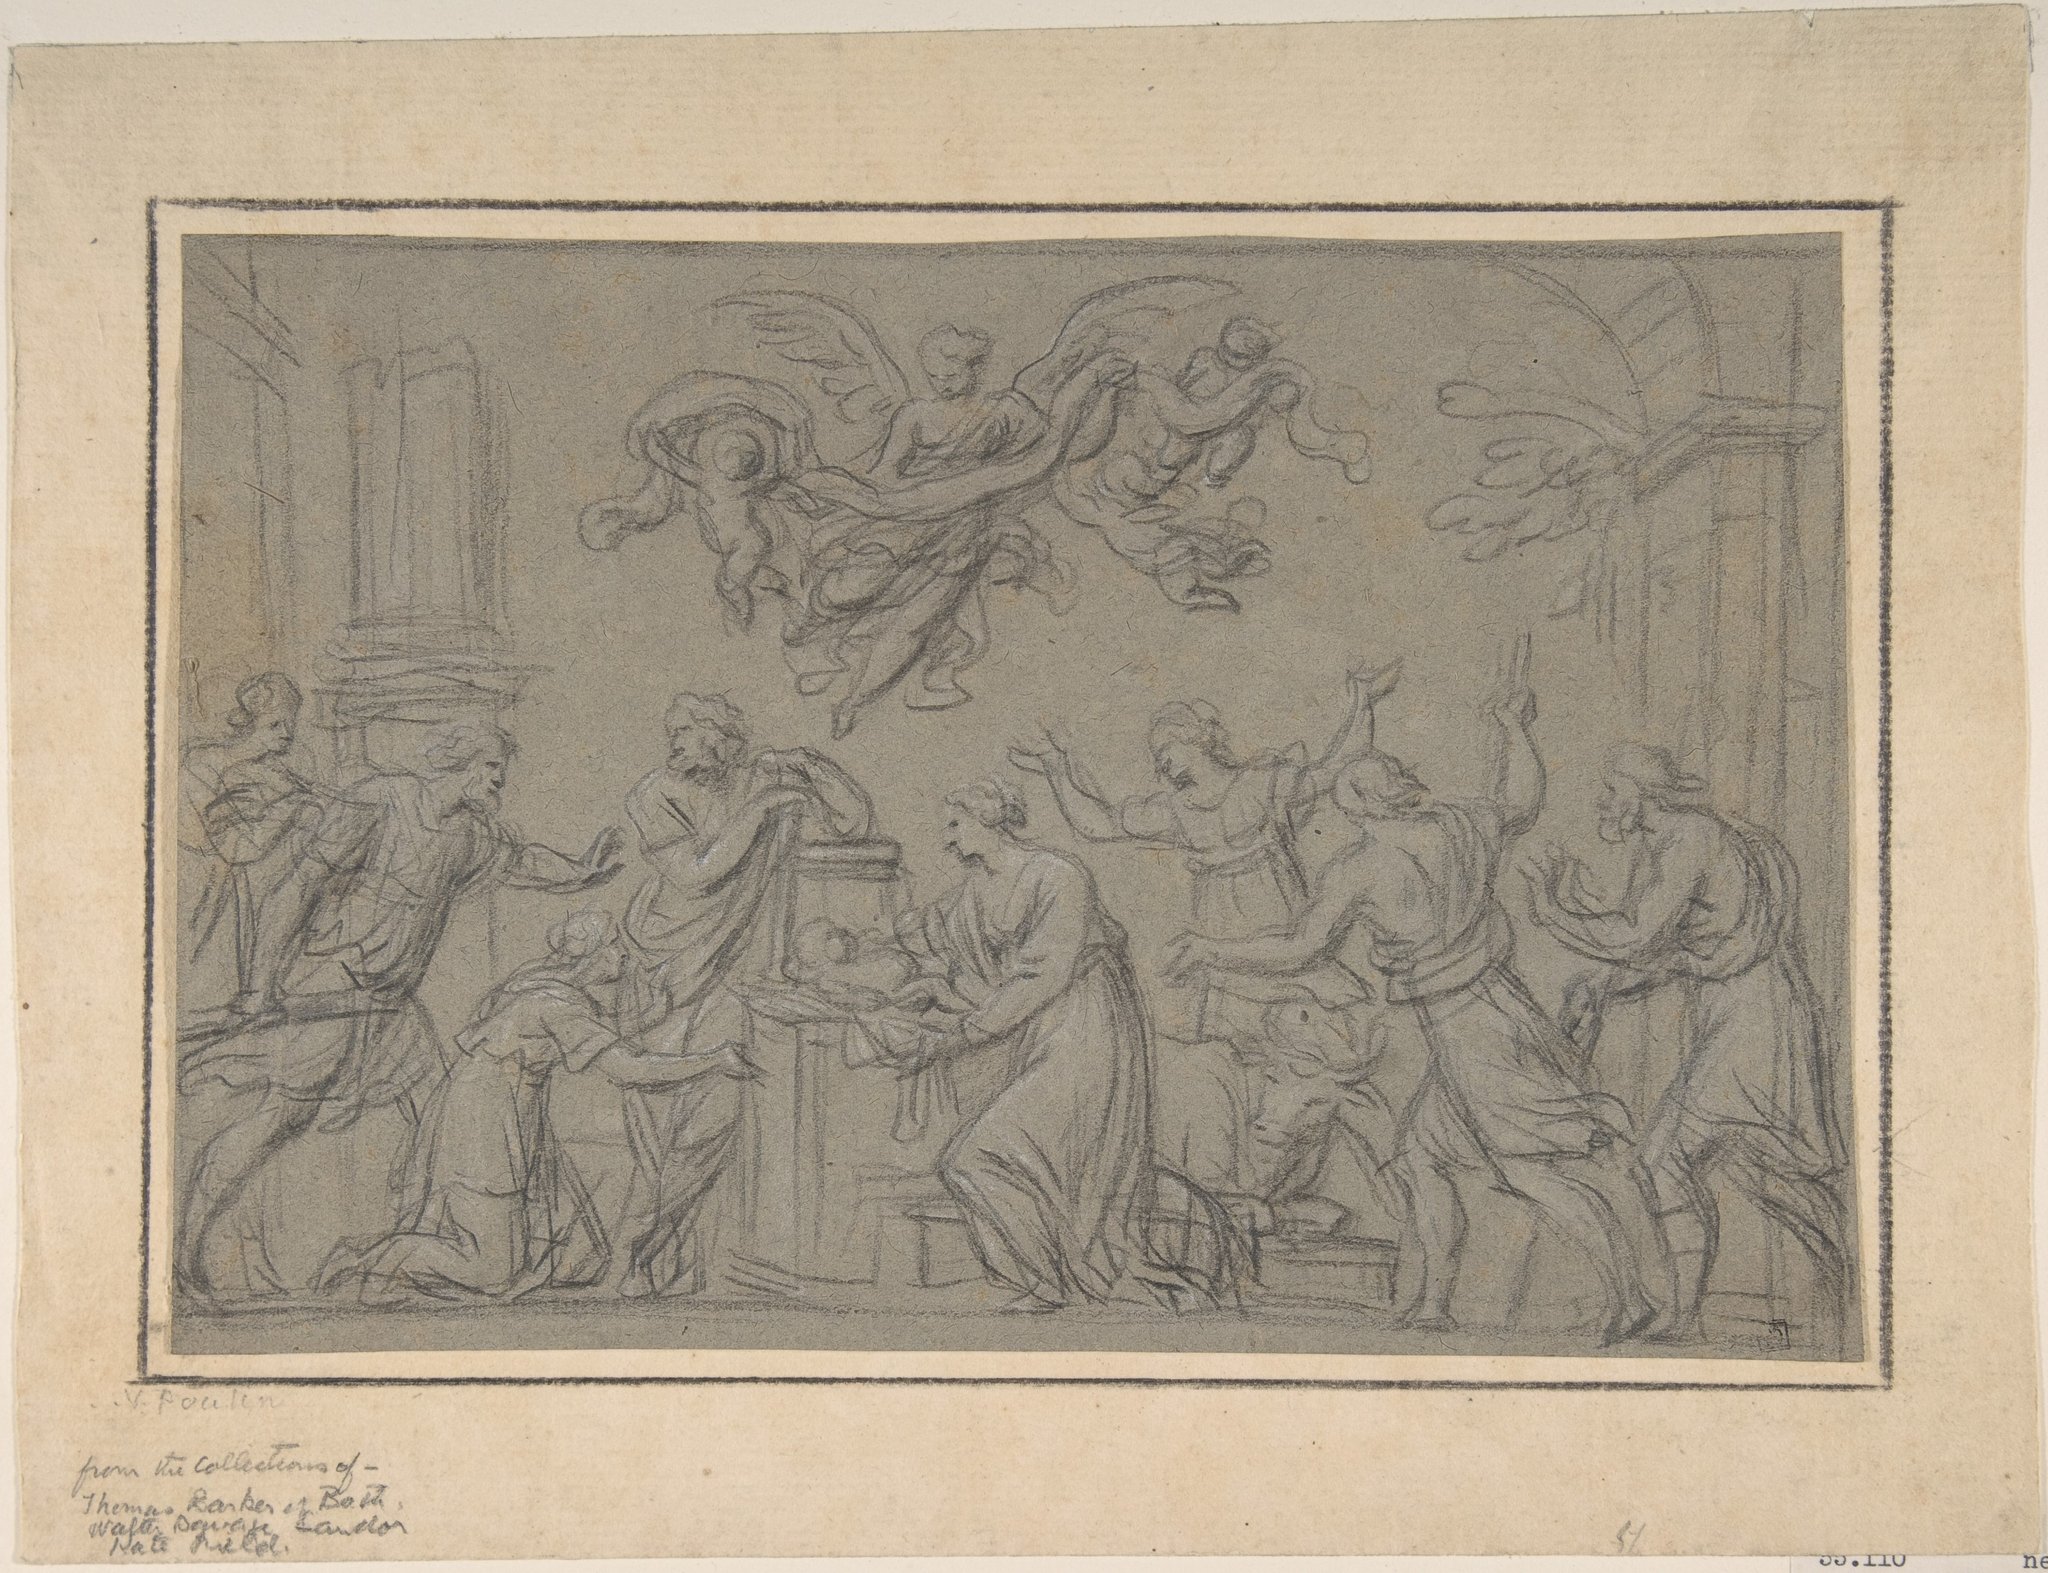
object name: drawing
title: The Nativity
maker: louis licherie de beurie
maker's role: artist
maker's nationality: french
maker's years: 1629-1687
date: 1629-1687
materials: chalk, paper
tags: angels,virgin mary,jesus,nativity